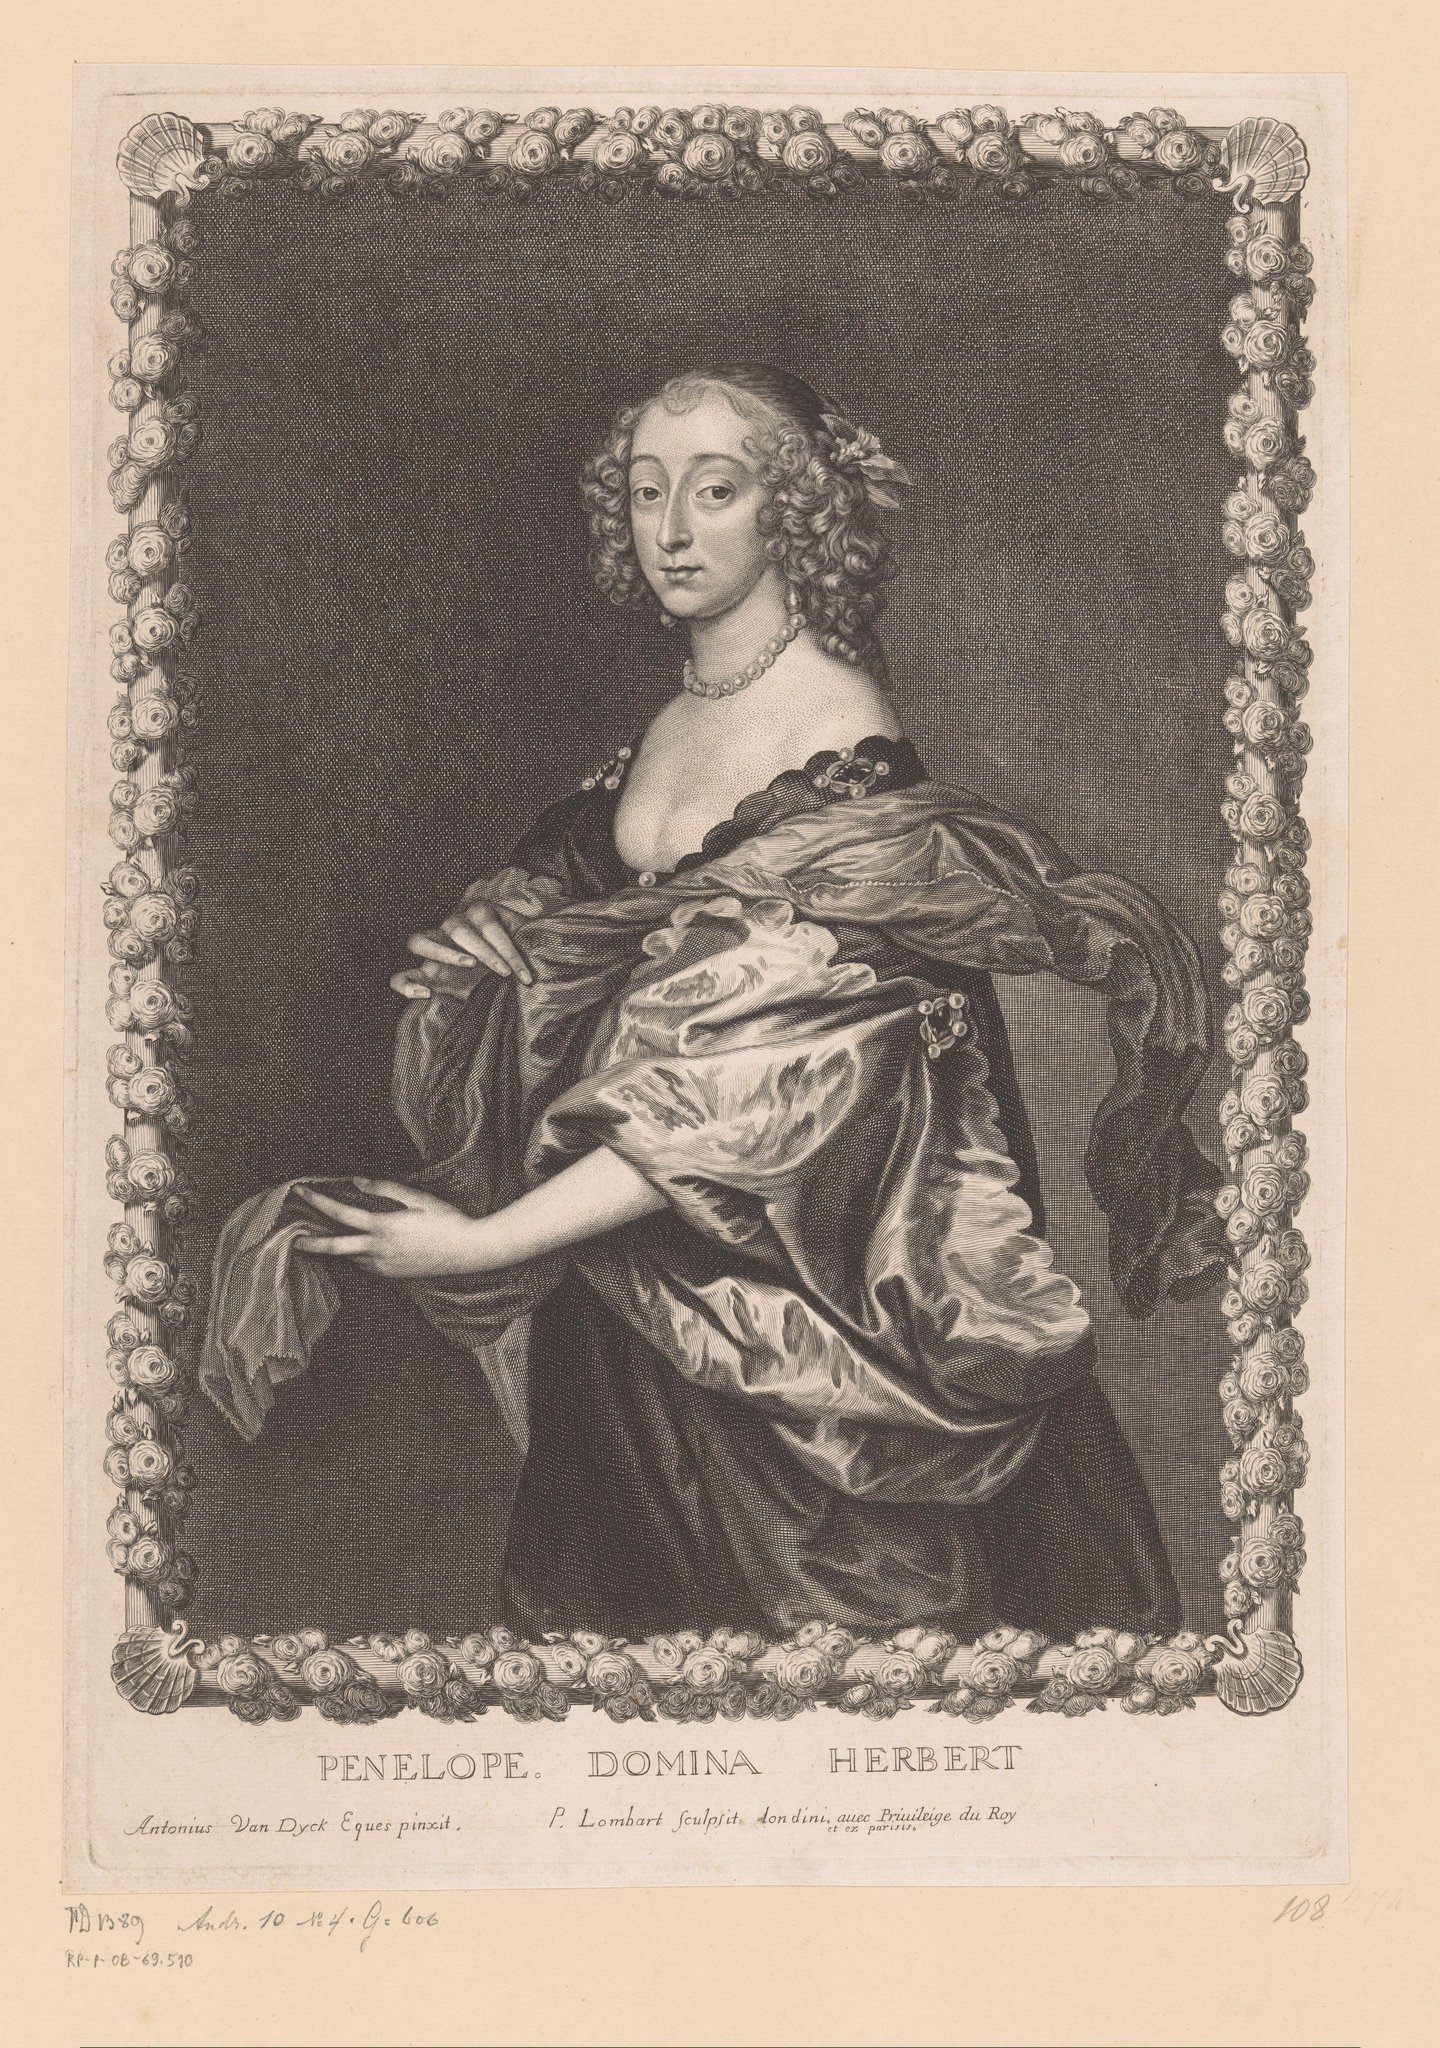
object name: print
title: Portret van Penelope Herbert in een versierde lijst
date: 1660-1663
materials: paper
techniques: engraving, etching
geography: london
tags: historical persons - bb - woman, frame of painting, etc.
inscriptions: collector's mark: Lugt 240